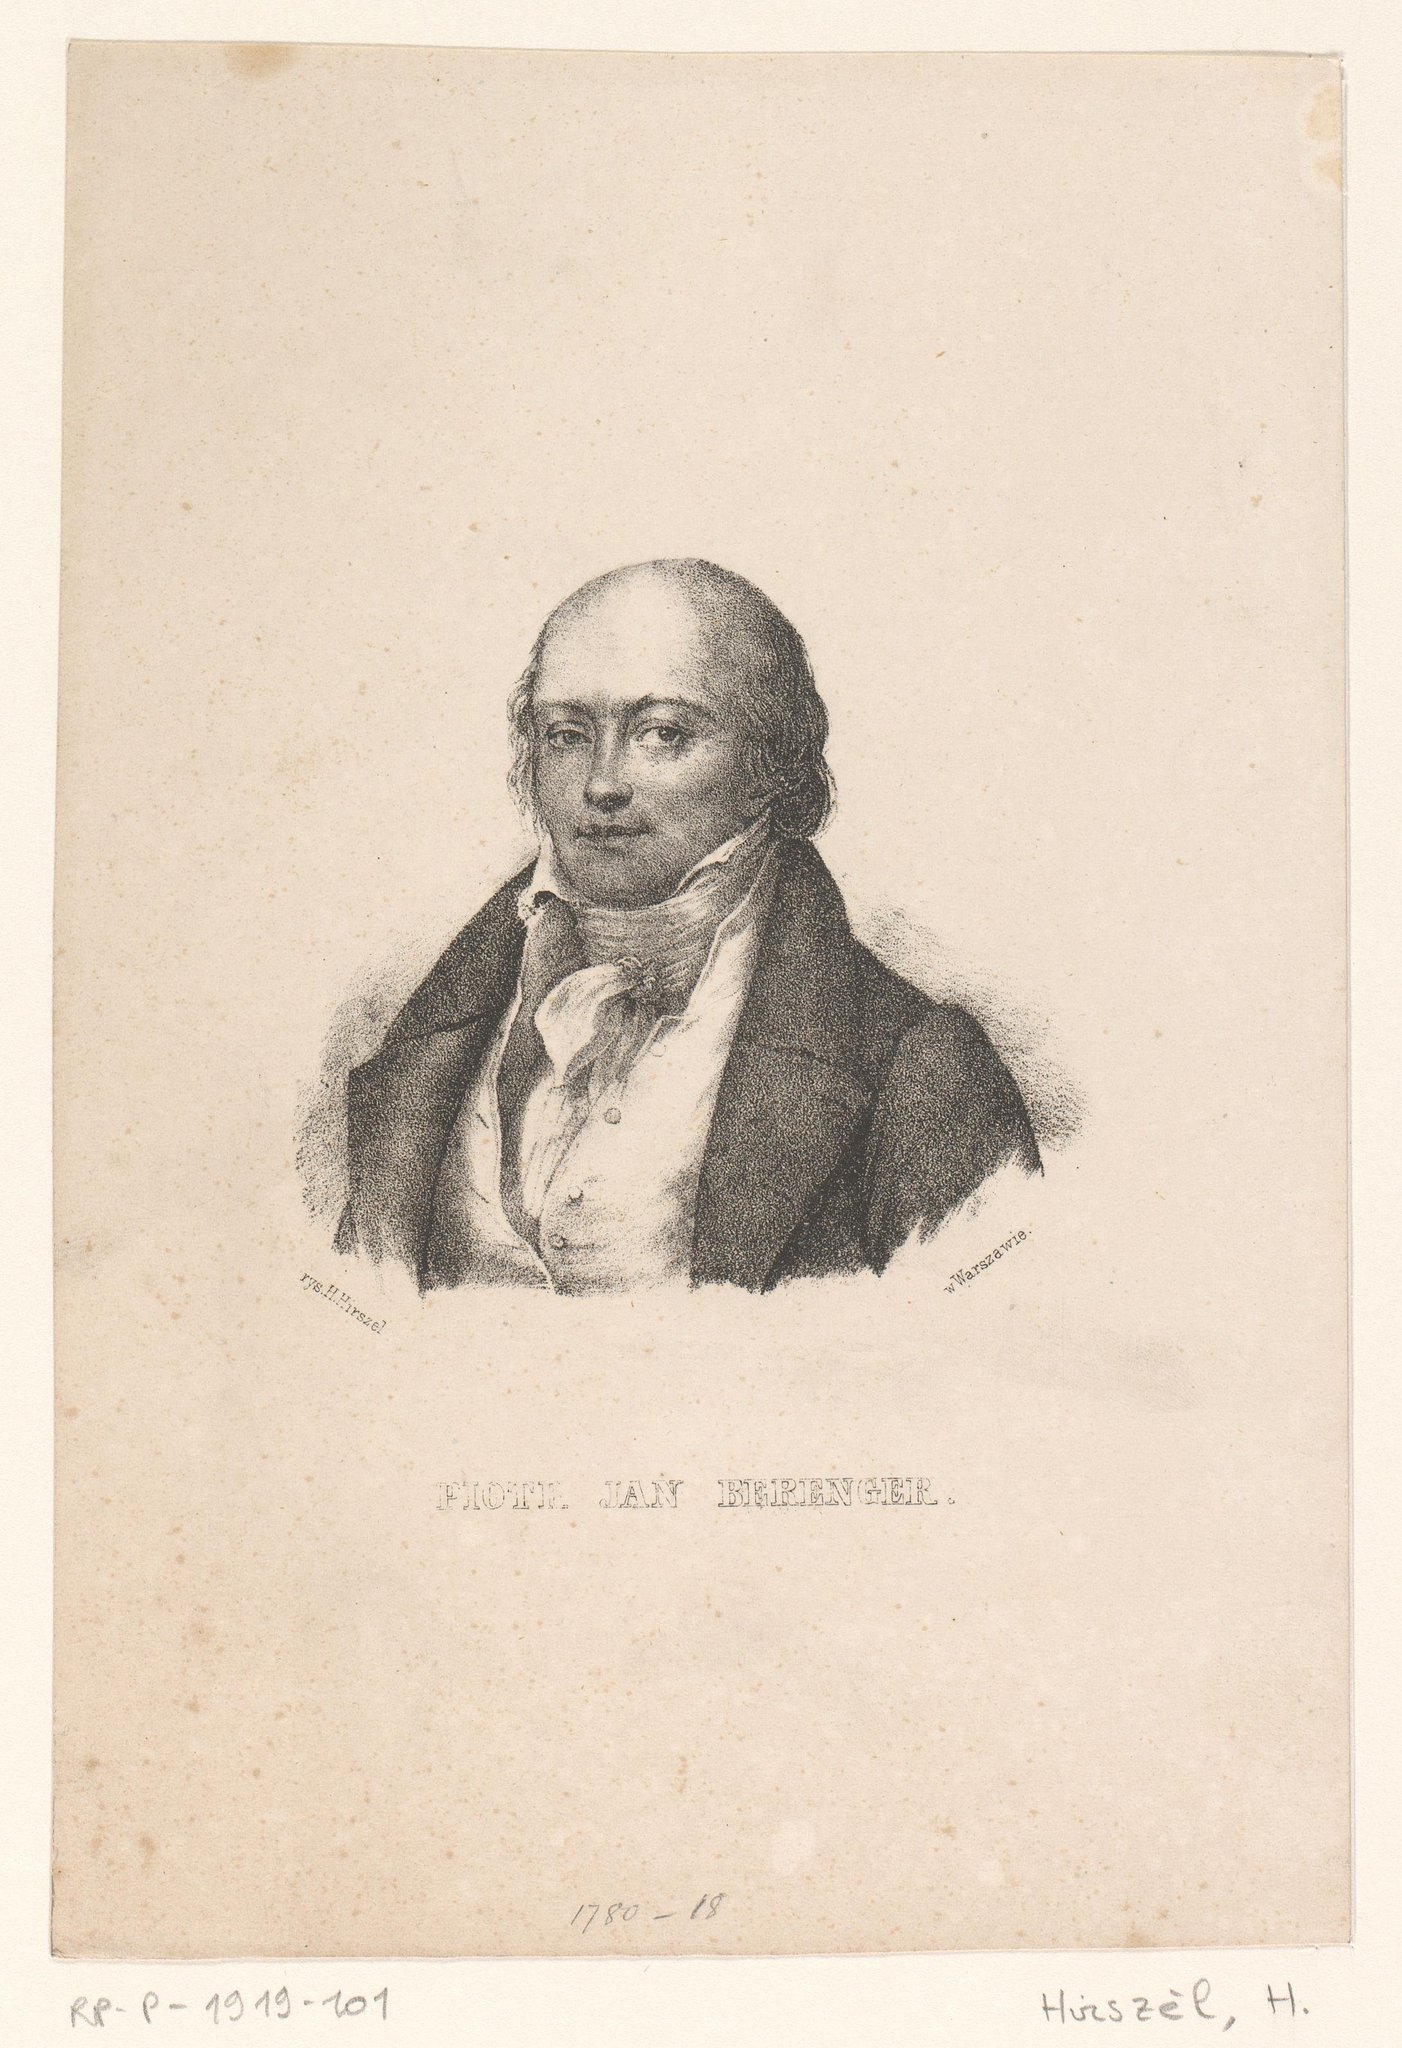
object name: print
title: Portret van Piotr Jan Berenger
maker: henrijk hirszèl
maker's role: print maker, printer, publisher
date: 1820-1860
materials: paper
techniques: lithograph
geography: warsaw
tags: adult man, historical persons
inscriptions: collector's mark: Lugt 2228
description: Prent mogelijk uit: Władysław Wójcicki, Kazimierz. Życiorysy znakomitych ludzi wsławionych w róznych zawodach: z rycinami. S.l.: J. Bernstein, 1850.